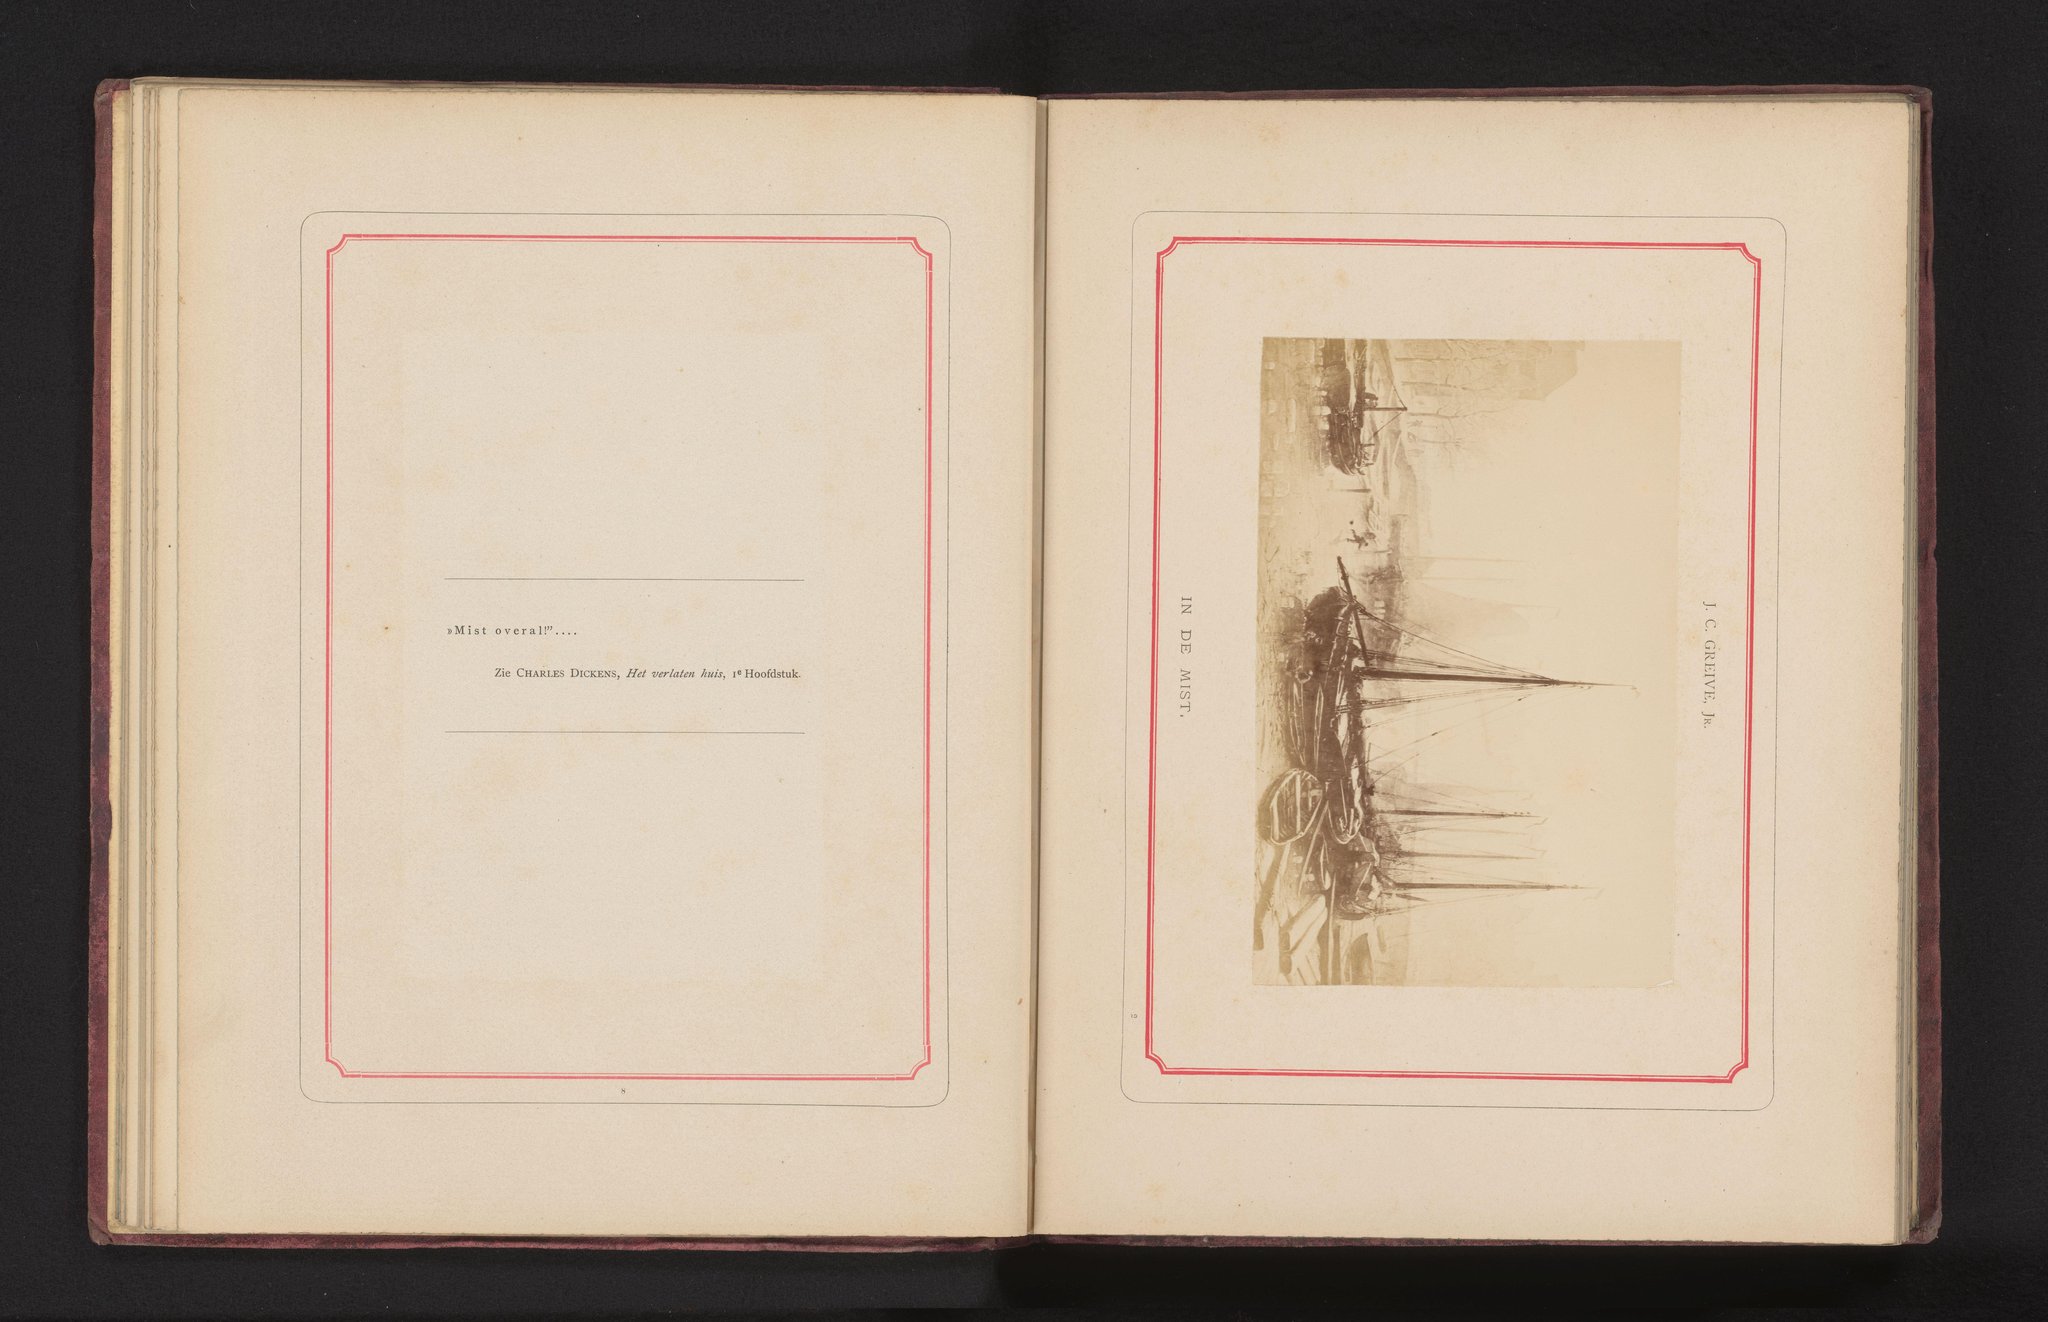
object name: page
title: Fotoreproductie van een schilderij, voorstellende schepen in een dichtgevroren haven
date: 1868-1878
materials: photographic support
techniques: albumen print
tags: harbour, ships (in general), ice ~ state of water